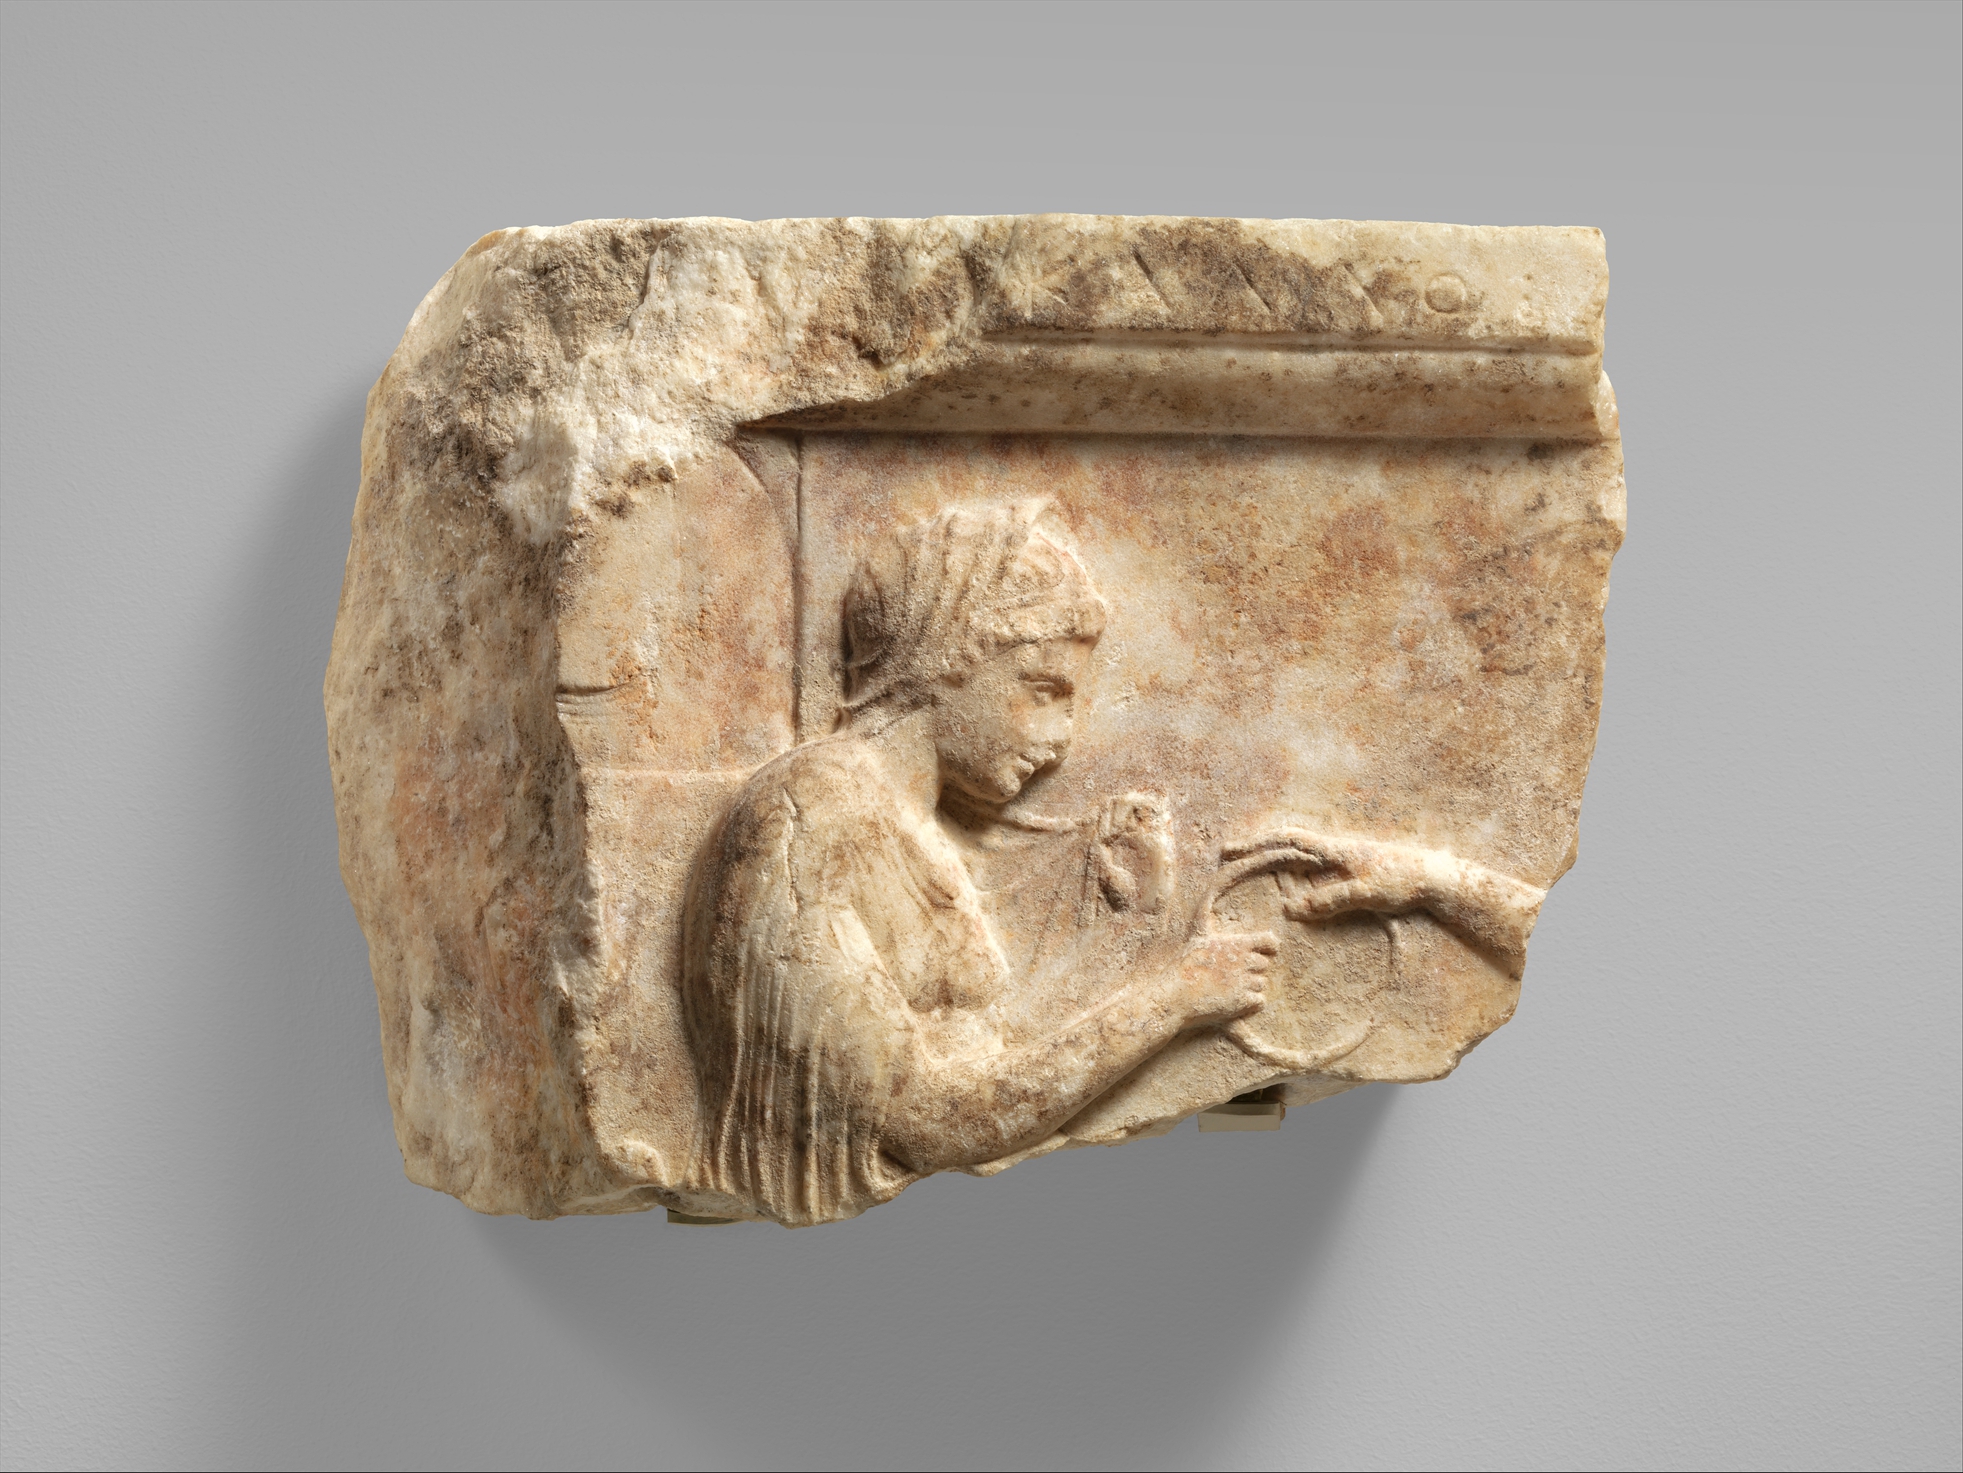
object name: relief fragment with kallo inscribed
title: Marble fragment of a hero relief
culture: greek, attic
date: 434-401 BCE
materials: marble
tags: profiles,women